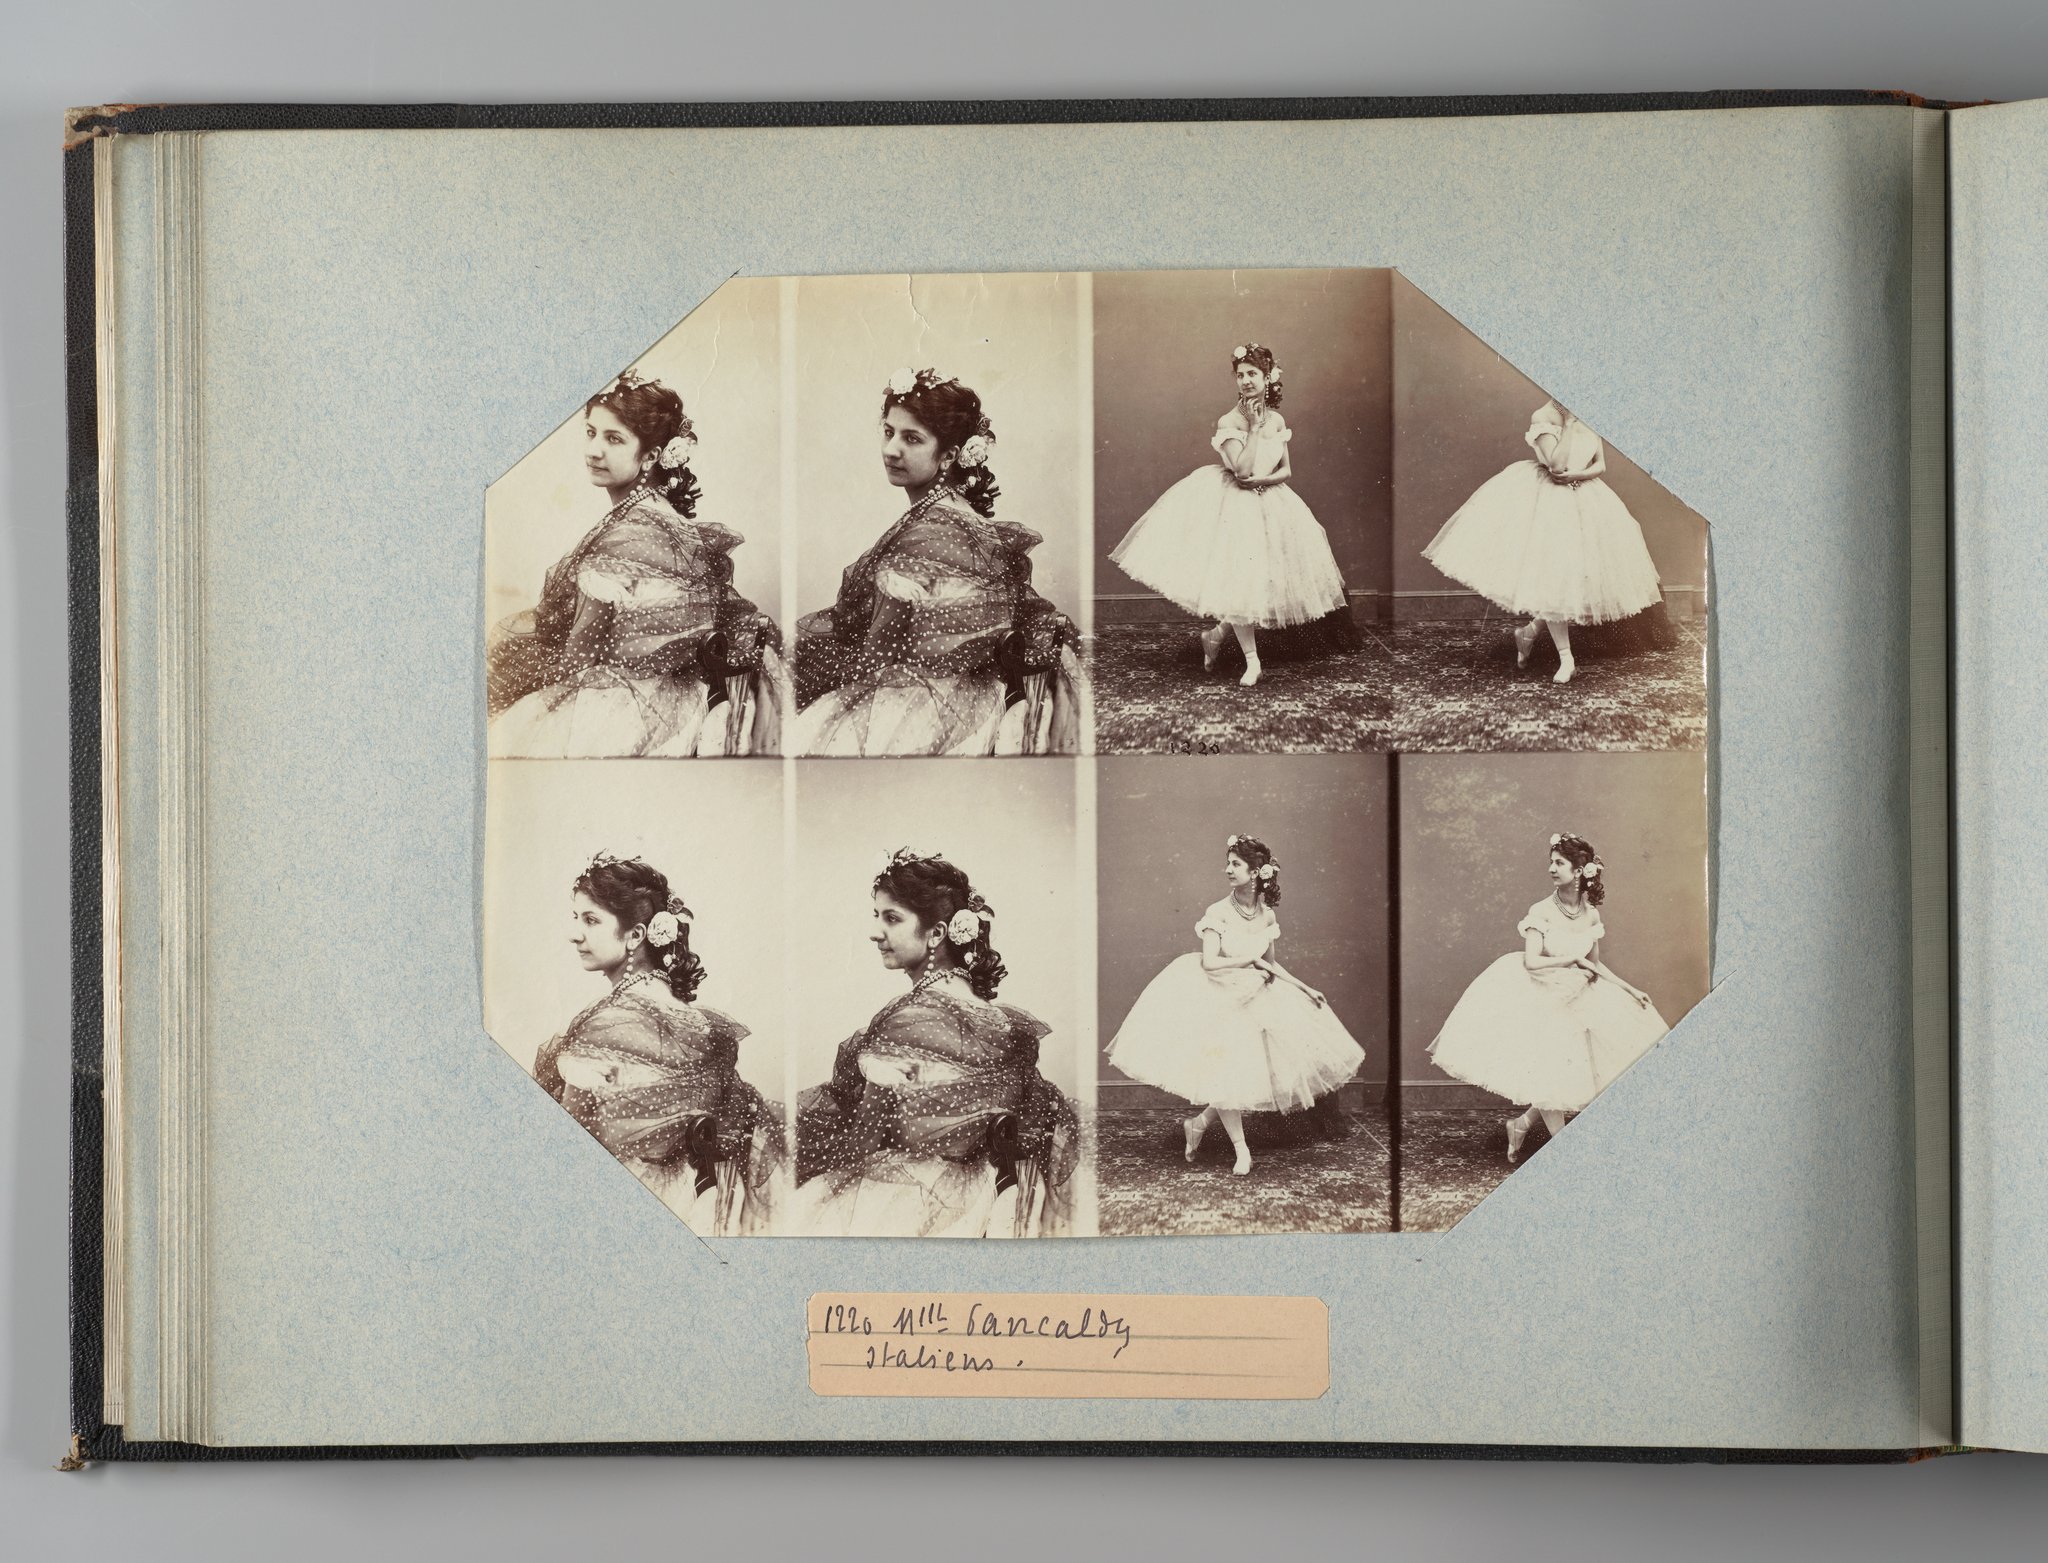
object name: photograph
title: Mlle Pancaldy - Italiens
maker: andré-adolphe-eugène disdéri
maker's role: artist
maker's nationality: french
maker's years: 1819-1889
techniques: albumen silver print, glass negative